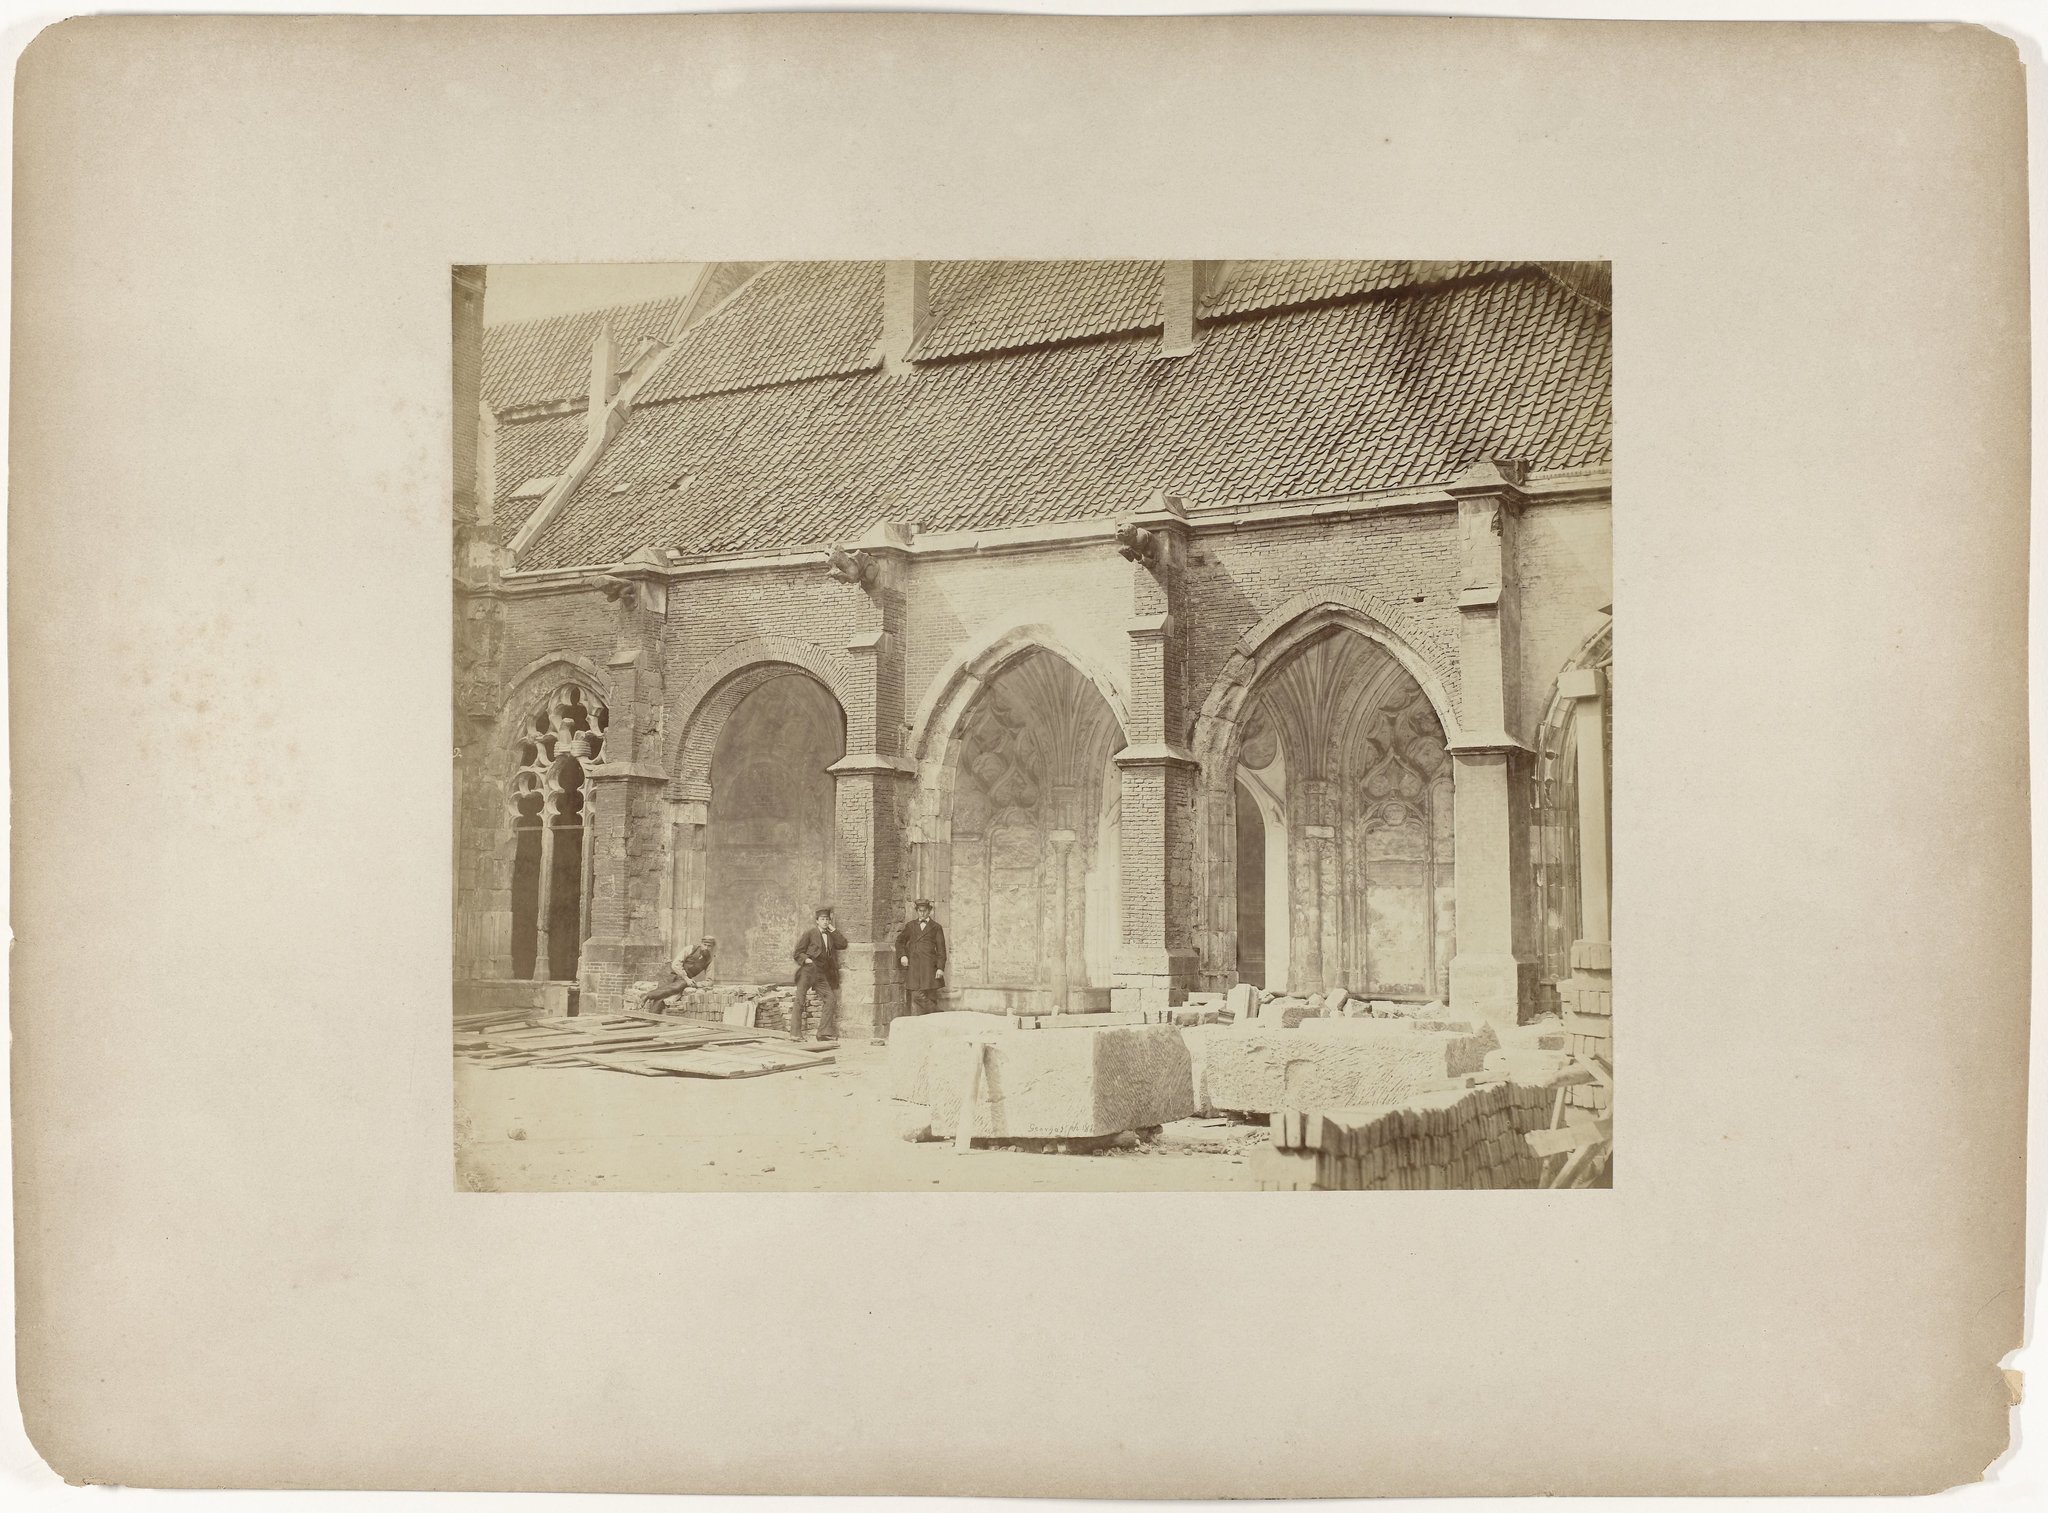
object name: photograph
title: Restauratie van de kloosteromgang van de Domkerk in Utrecht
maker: eduard françois georges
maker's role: sculptor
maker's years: 1817-1895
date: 1880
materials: cardboard, photographic support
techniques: albumen print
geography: utrecht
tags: church (exterior), restoration of a work of art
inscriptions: inscription